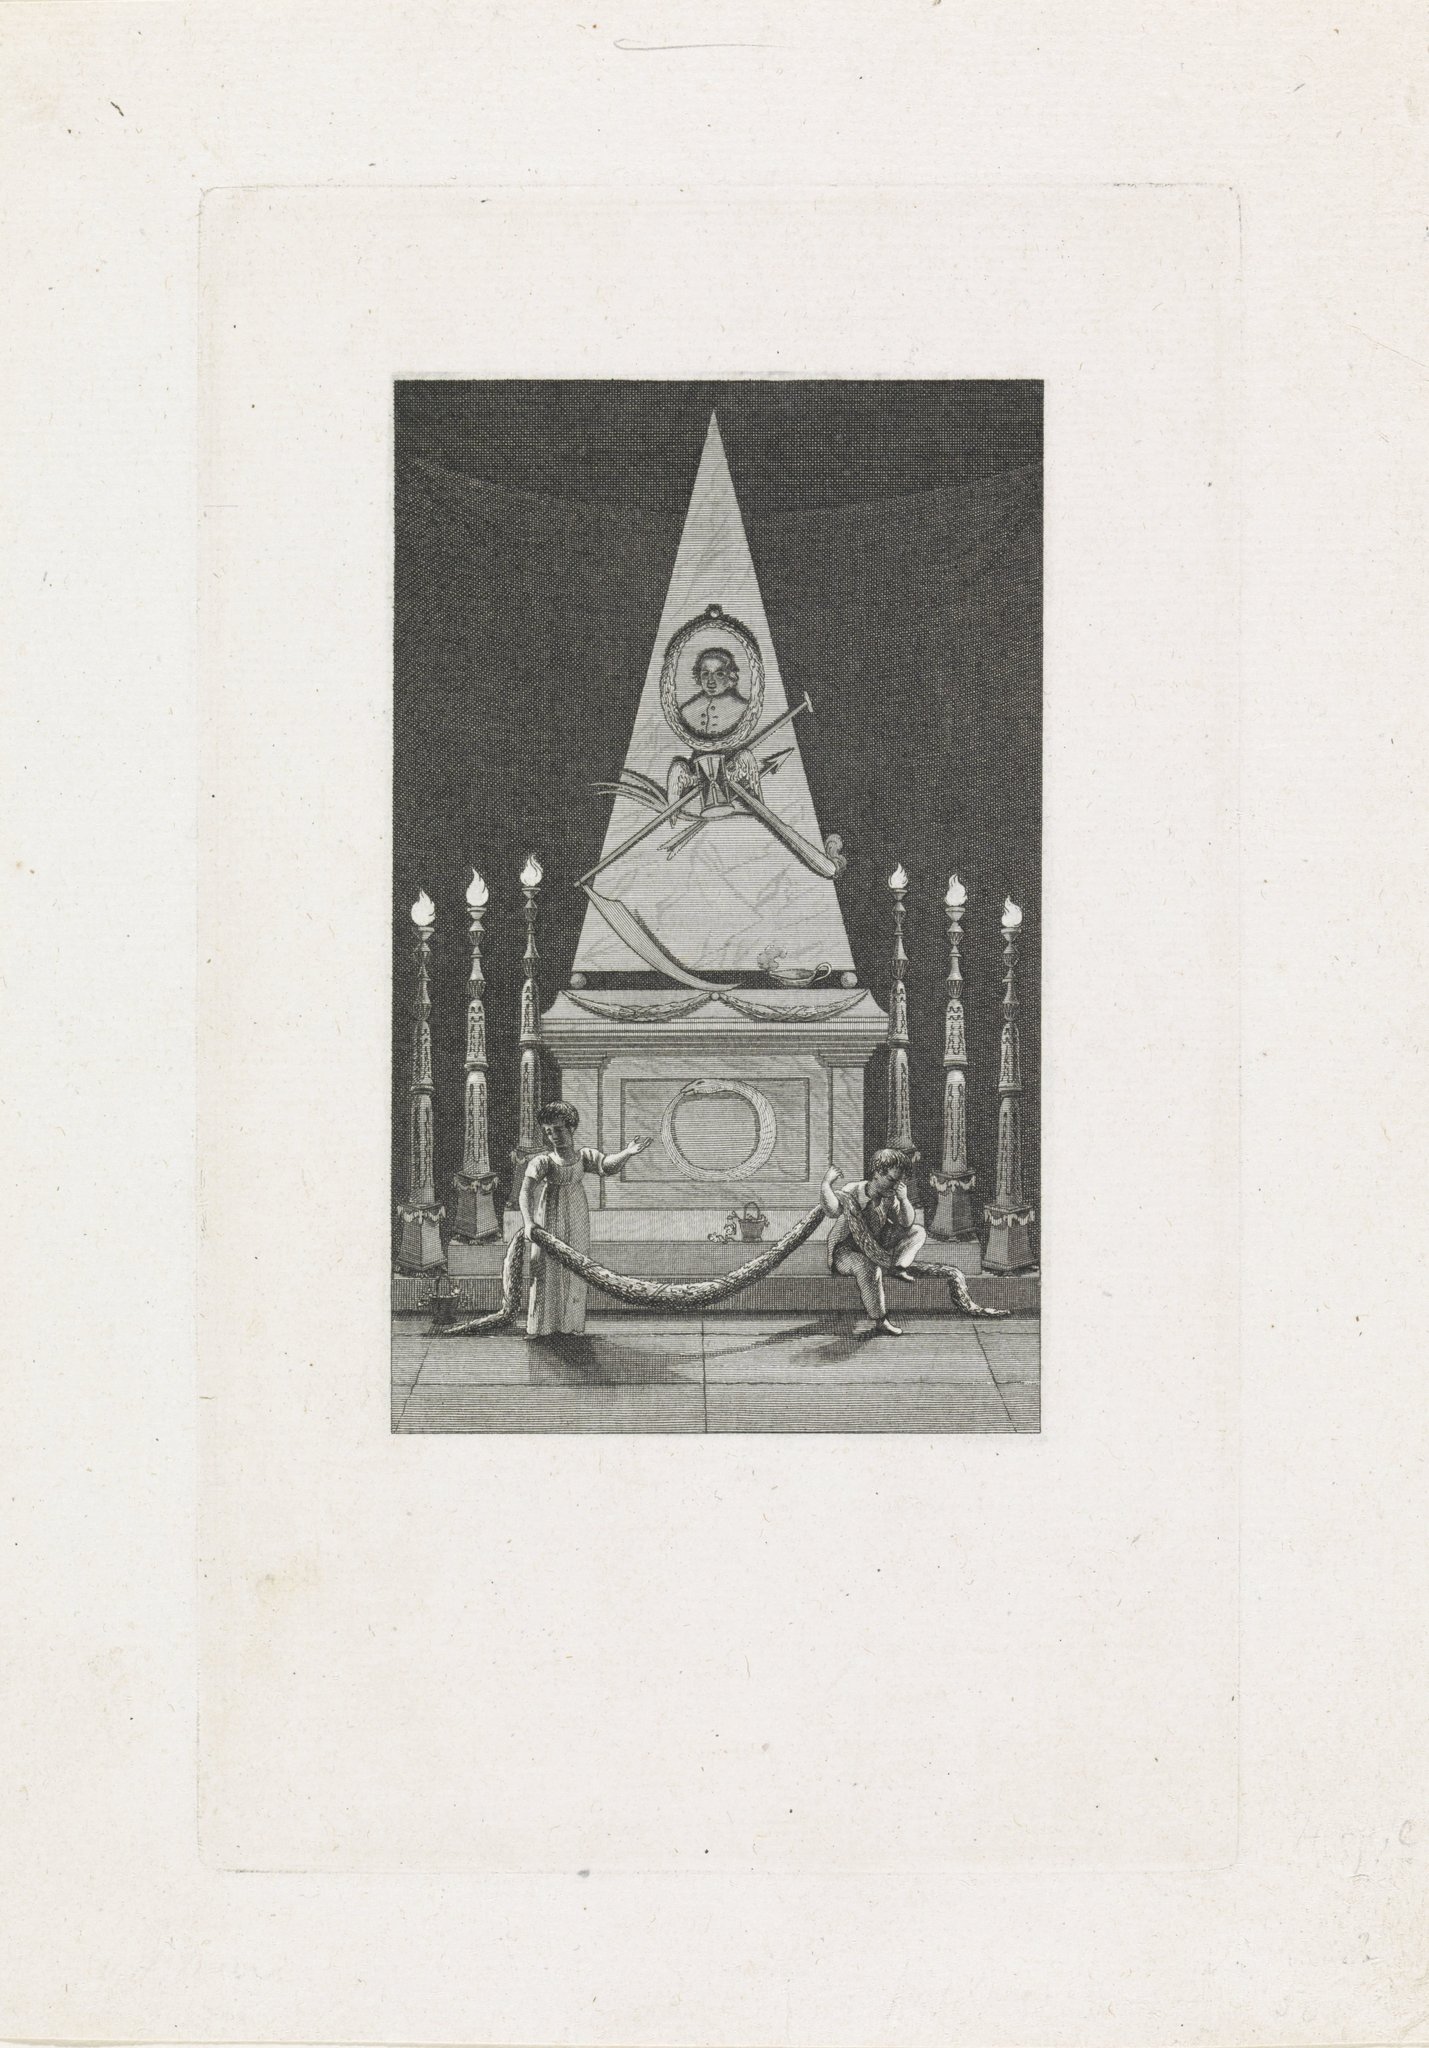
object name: print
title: Allegorisch grafmonument voor Jan Nieuwenhuyzen, 1806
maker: Anonymous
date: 1807-1808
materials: paper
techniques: etching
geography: netherlands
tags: haarlem, amsterdam, jan nieuwenhuyzen, grave-building, monumental tomb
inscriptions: collector's mark: Lugt 2228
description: Allegorisch grafmonument voor de op 24 februari 1806 overleden Jan Nieuwenhuyzen, oprichter van de Maatschappij tot Nut van 't Algemeen. Tombe met piramide met zes brandende olielampen. Voor het monument twee kinderen met een guirlande.